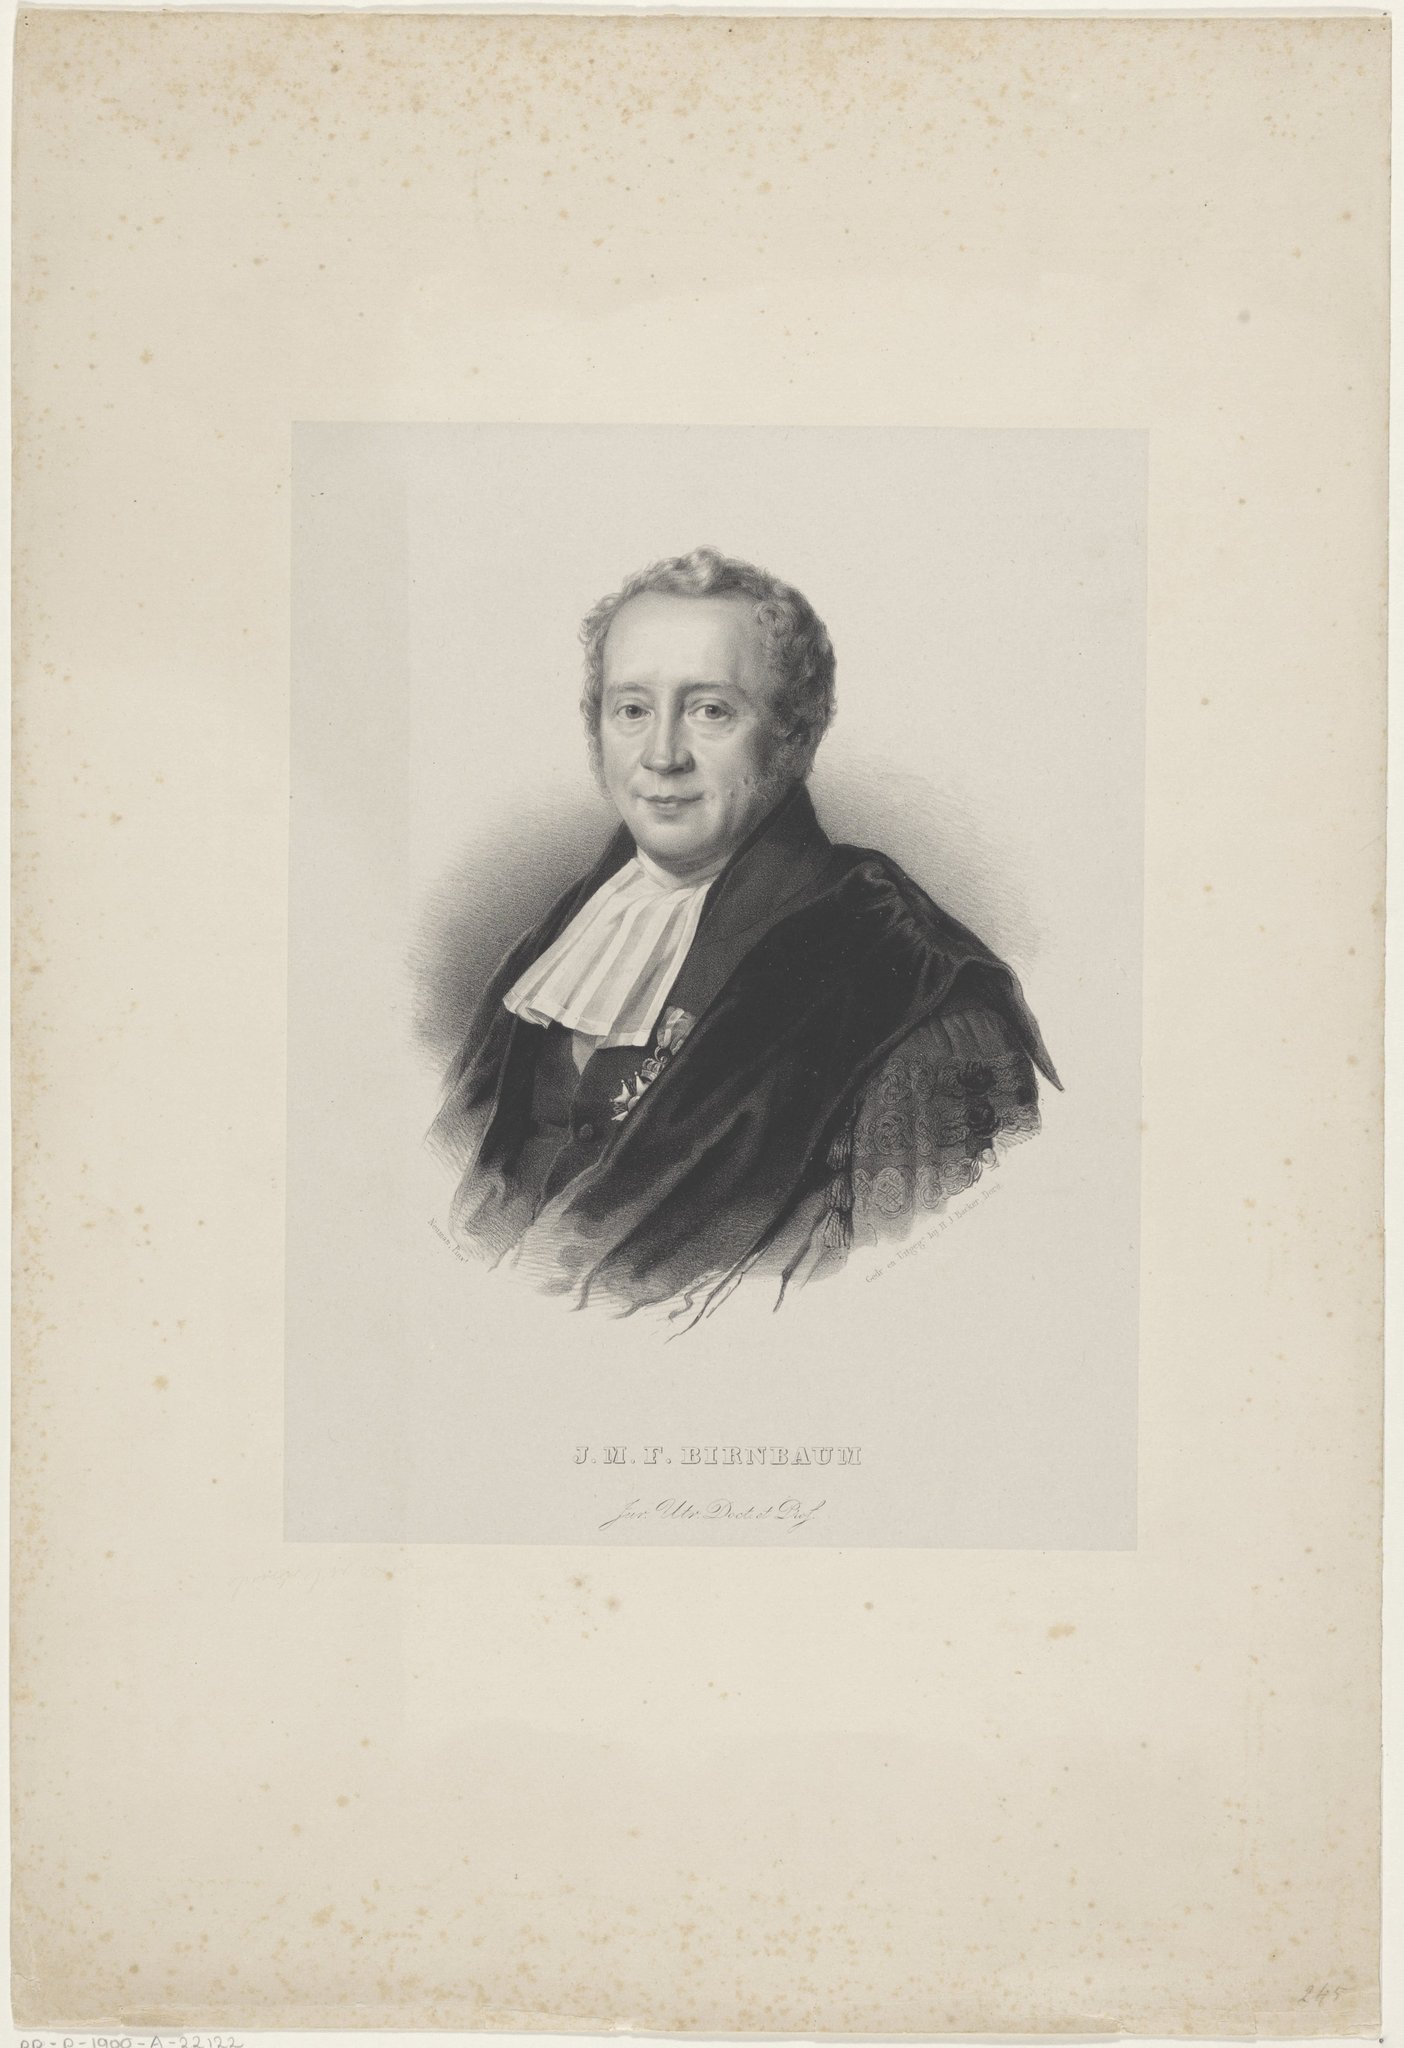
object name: print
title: Portret van Johann Michael Franz Birnbaum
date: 1822-1845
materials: paper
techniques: lithograph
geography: dordrecht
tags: knighthood order, historical persons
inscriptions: collector's mark: Lugt 2228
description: De geportreerde draagt een toga en een ridderorde. Onder het portret zijn naam en titels.